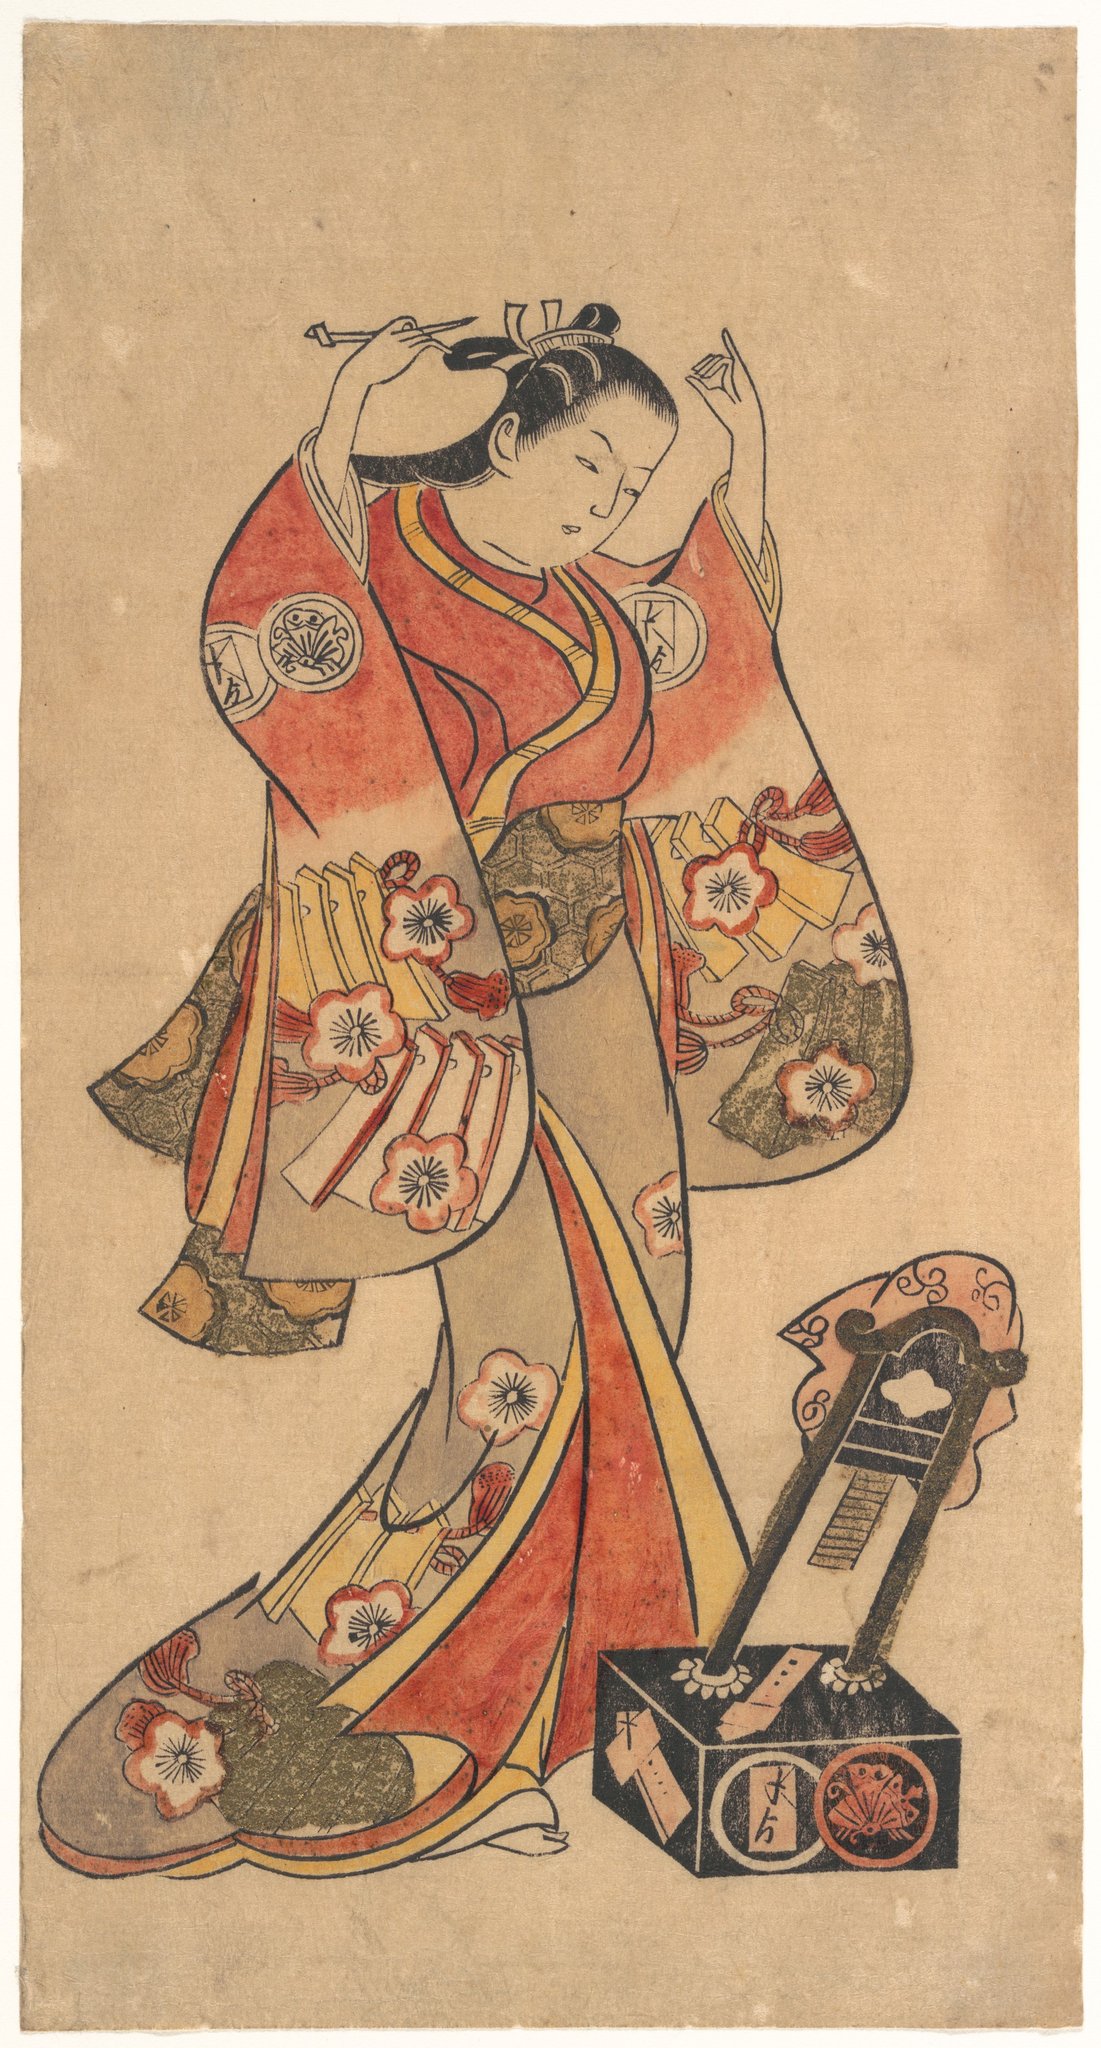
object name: print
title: Portrait of Sanjō Kantarō in the Female Role of Yaoya Oshichi in the Play "Fuji no Takane" ("The High Peak of Mount Fuji")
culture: japanese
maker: torii kiyomasu ii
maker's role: artist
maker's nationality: japanese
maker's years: 1706-1763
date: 1730-1740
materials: ink, paper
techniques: hand coloring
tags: men,women,actors,mirrors